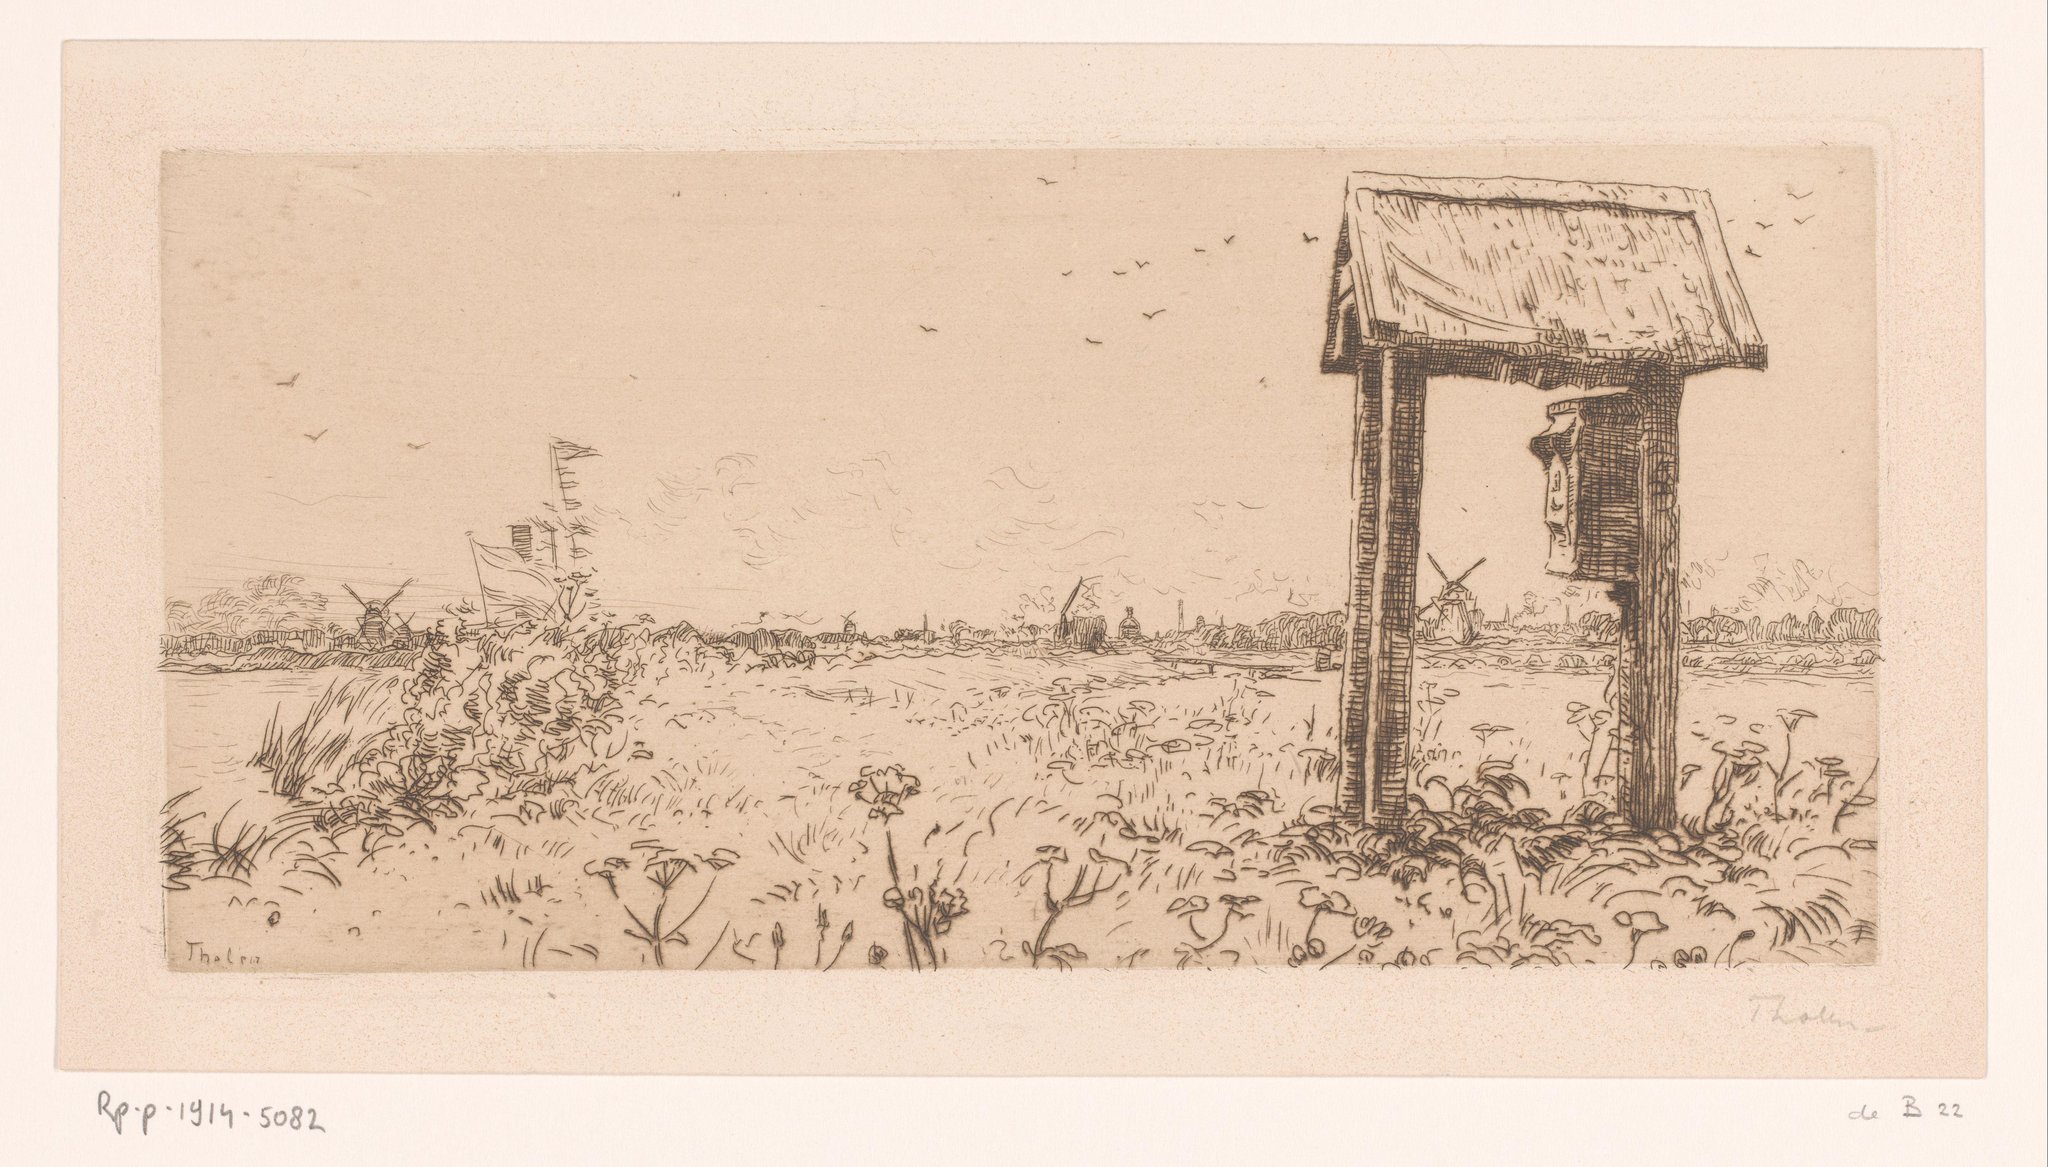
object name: print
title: Brievenbus, Kaag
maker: willem bastiaan tholen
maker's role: draughtsman, painter, print maker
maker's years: 1860-1931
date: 1870-1914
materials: paper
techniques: etching, intaglio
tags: postal service, meadow, pasture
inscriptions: collector's mark: Lugt 2228